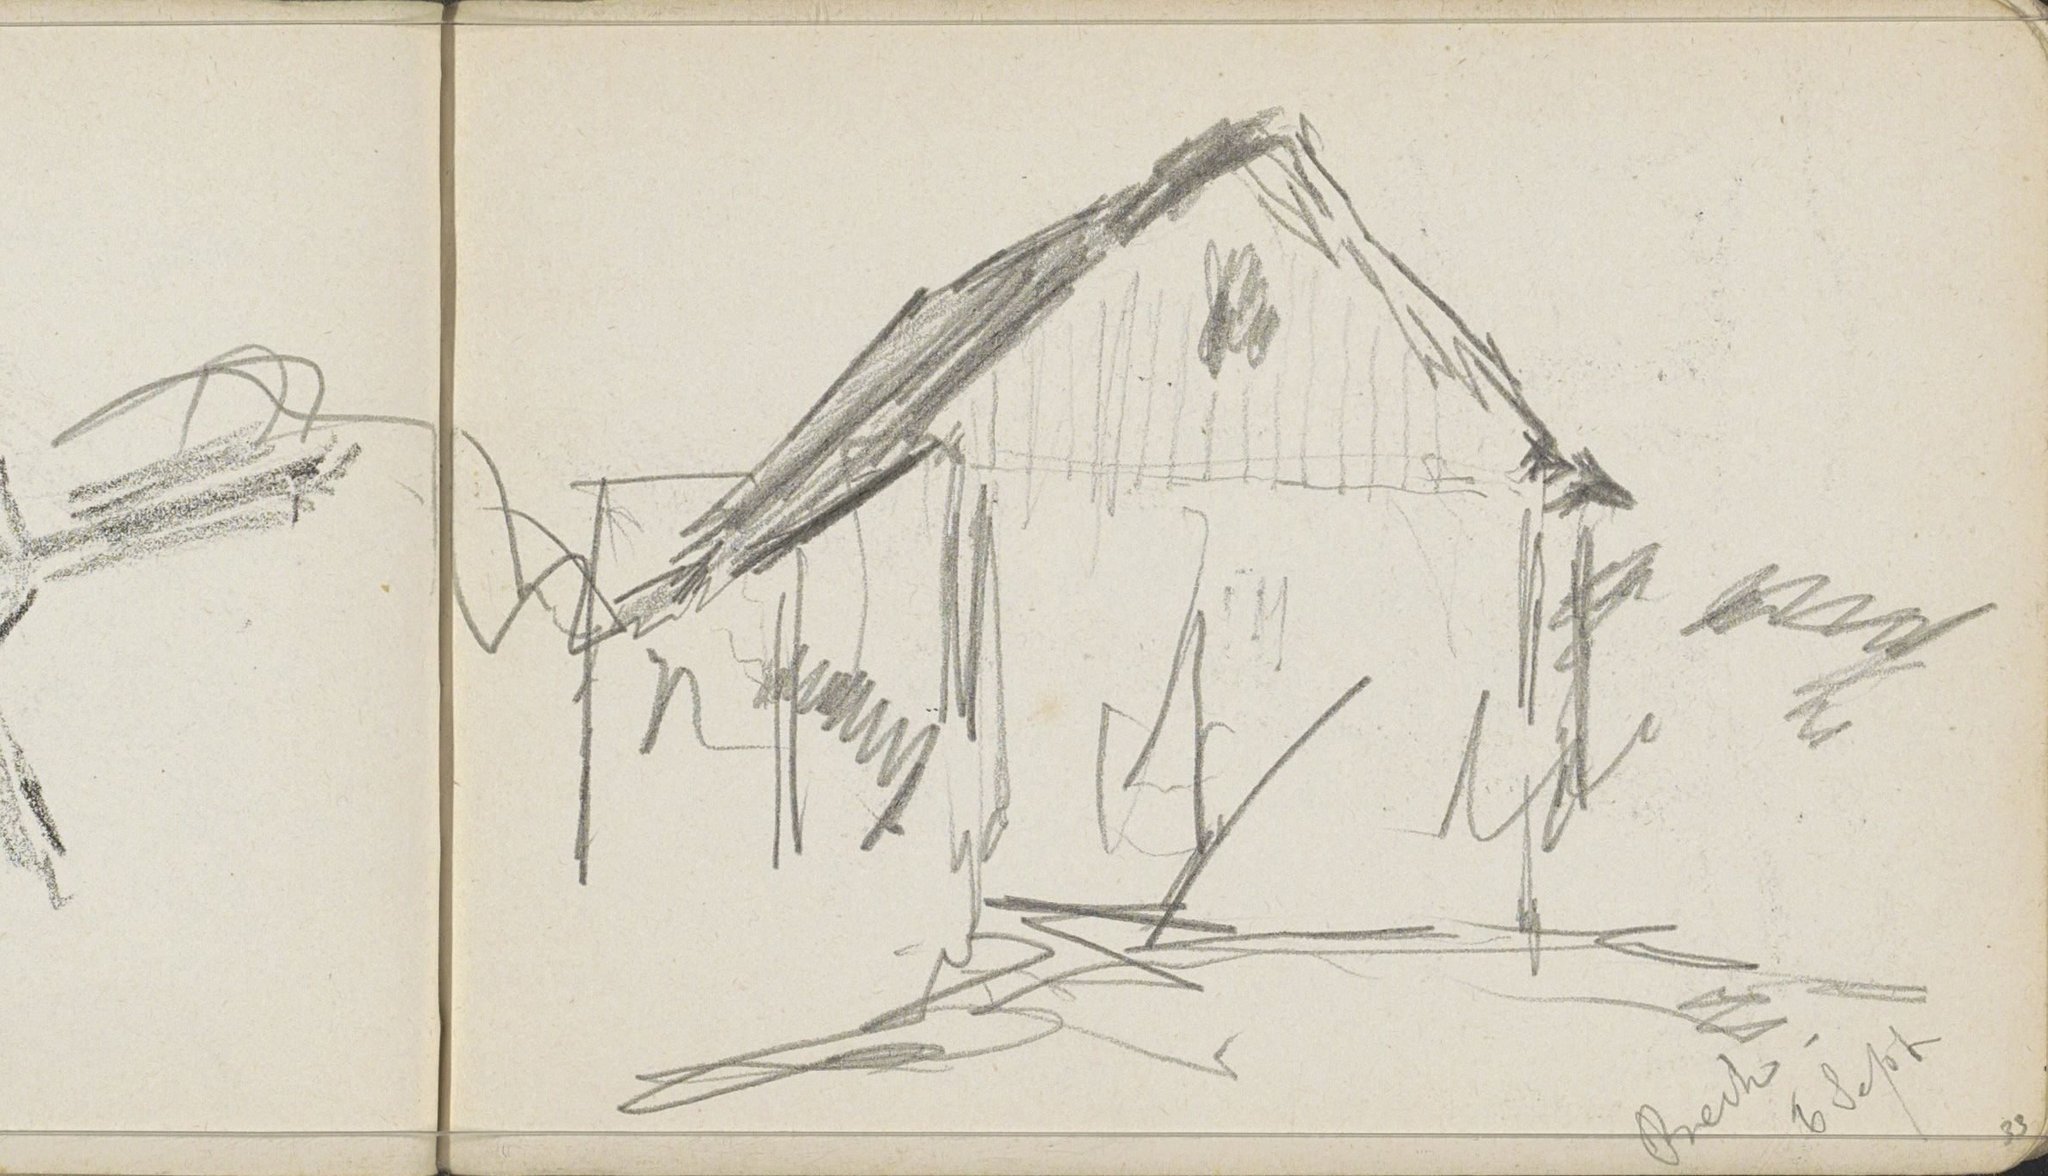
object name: sketchbook leaf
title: Huis te Beek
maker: willem cornelis rip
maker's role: draughtsman, painter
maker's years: 1856-1922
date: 1905-1909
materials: paper, pencil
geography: beek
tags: the usual house or row of houses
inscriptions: date and inscription: ‘Beek/ 6 Sept’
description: Blad 33 recto uit een schetsboek met 42 bladen.